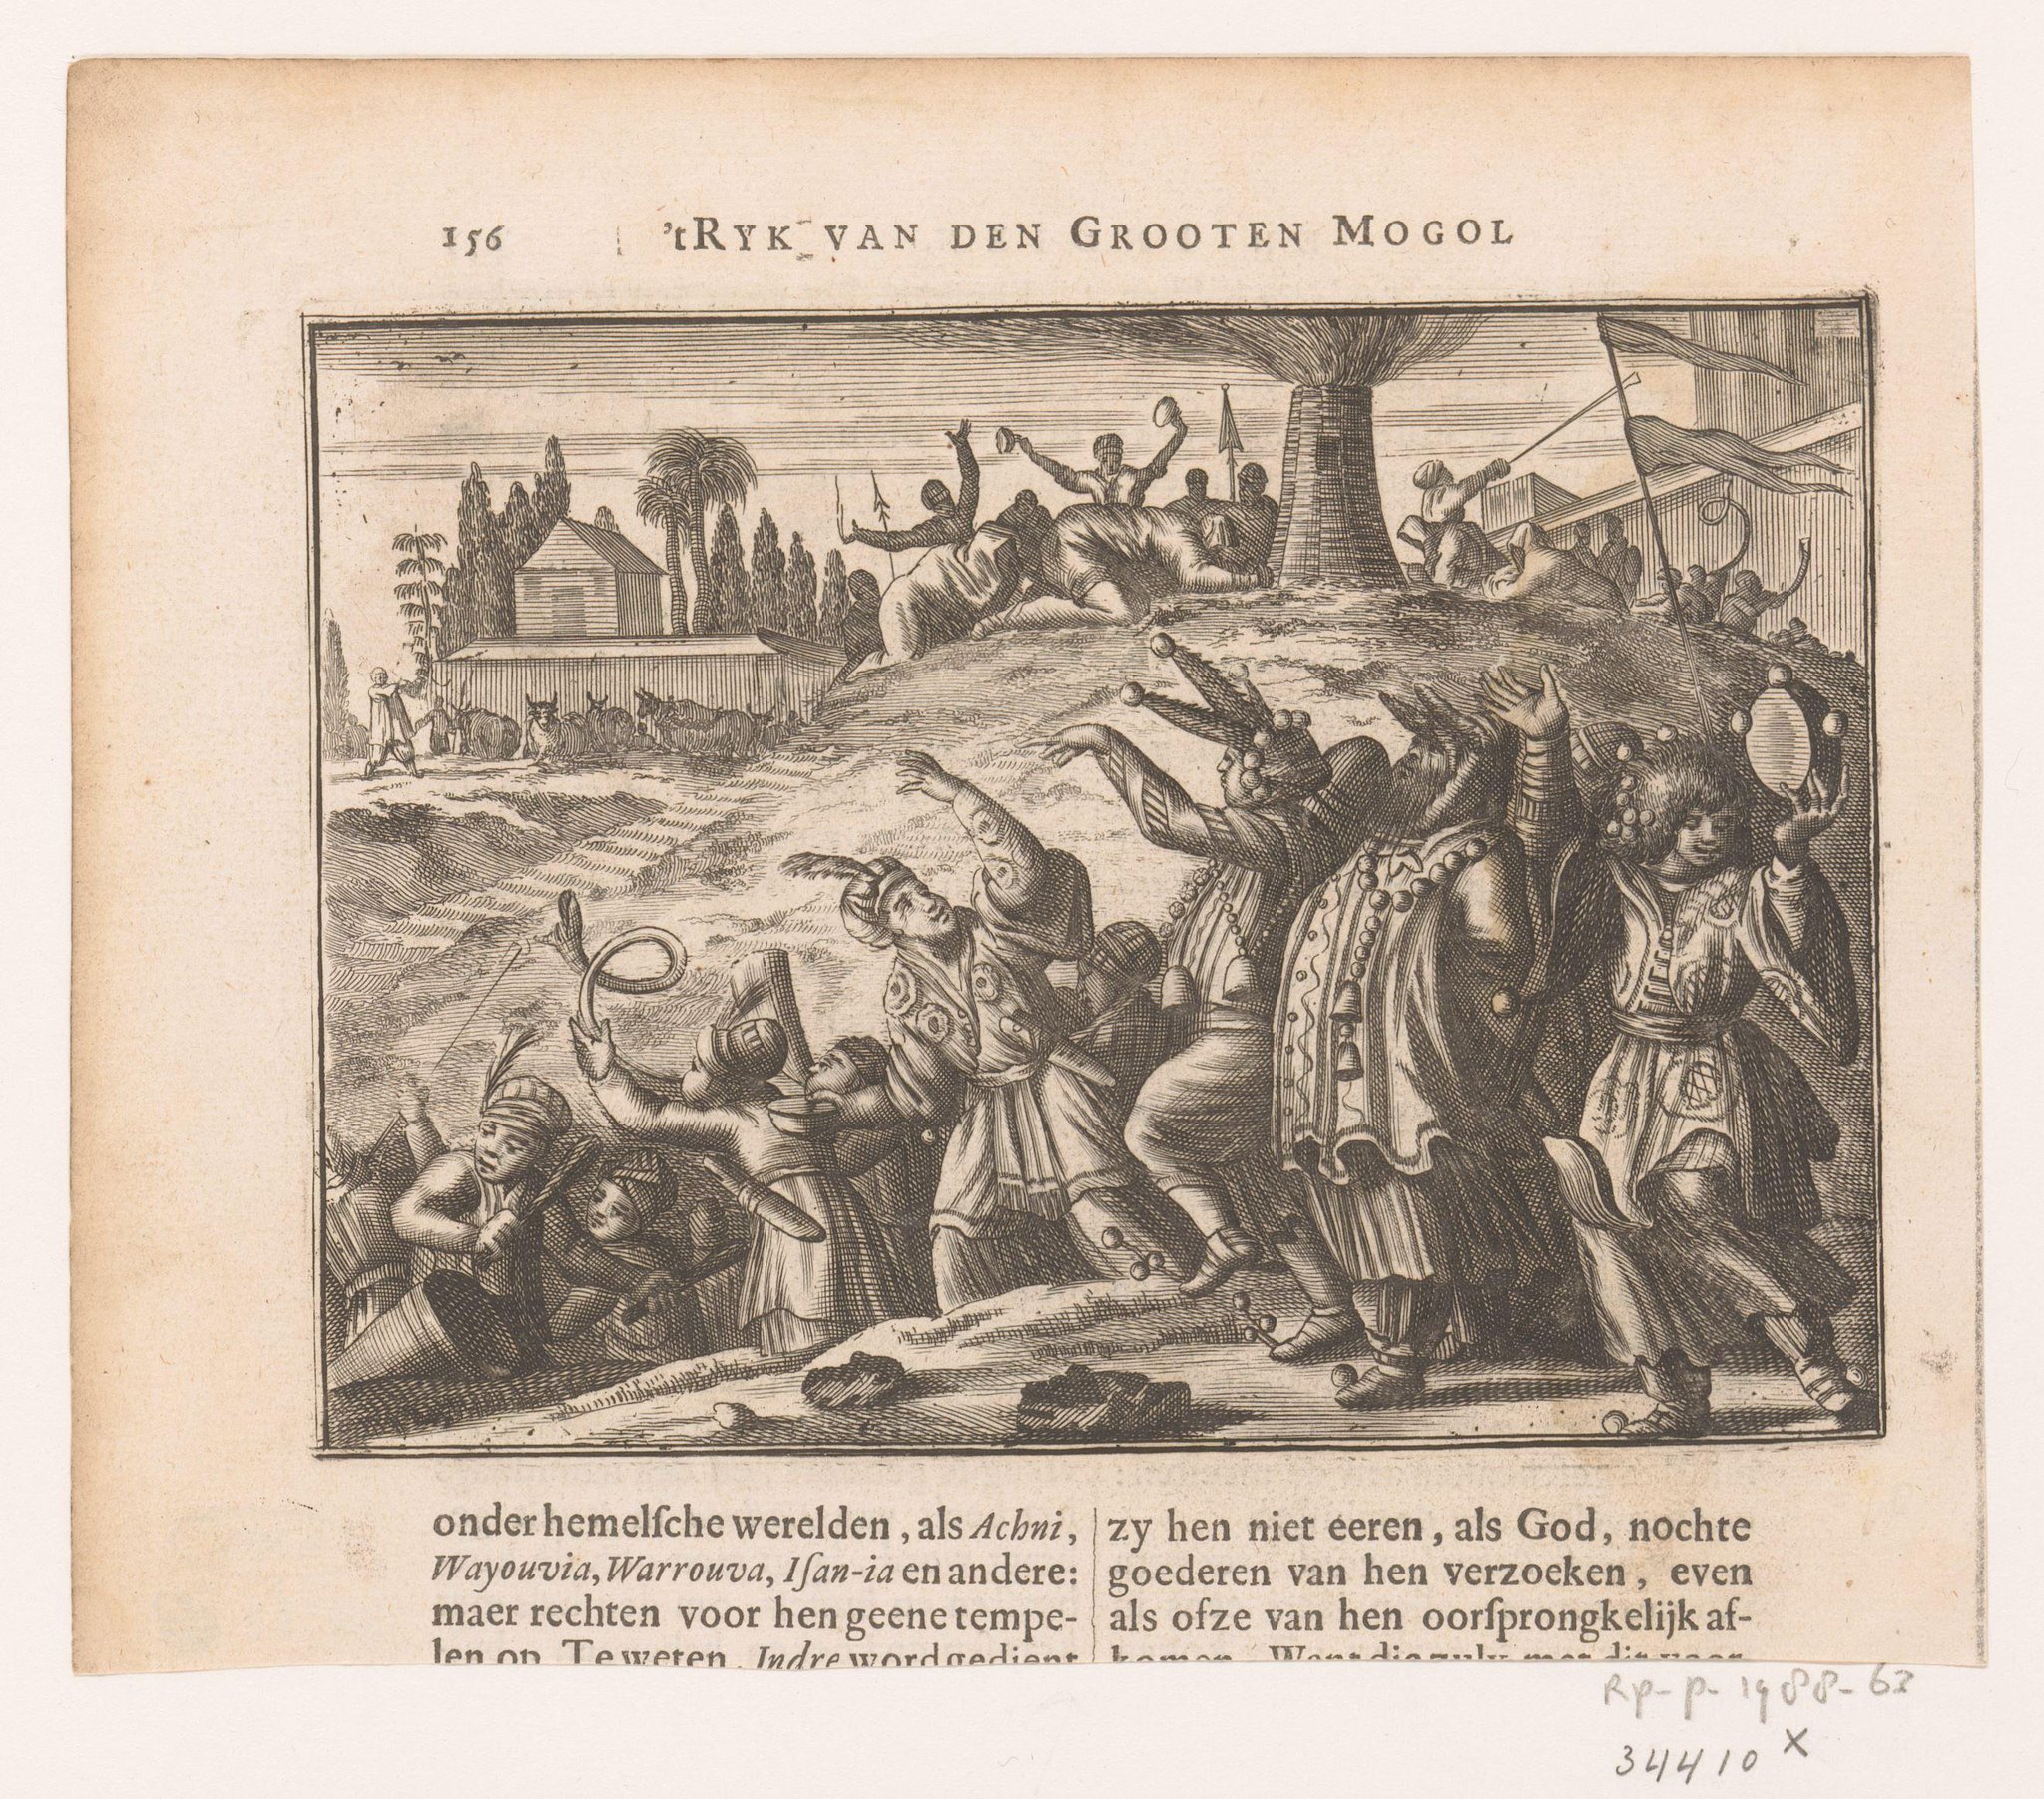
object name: book illustration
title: Feestelijke optocht tijdens het Holifeest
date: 1672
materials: paper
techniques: engraving, etching, letterpress printing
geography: amsterdam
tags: worship and devotion (in general) ~ hinduism, buddhism, jainism, fantasy costume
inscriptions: collector's mark: Lugt 2228, collector's mark: Lugt 2760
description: Prent uit: Dapper, Olfert. Asia, of naukeurige beschryving van het rijk des grooten Mogols (...). Amsterdam: Jakob van Meurs, 1672, p. 156.